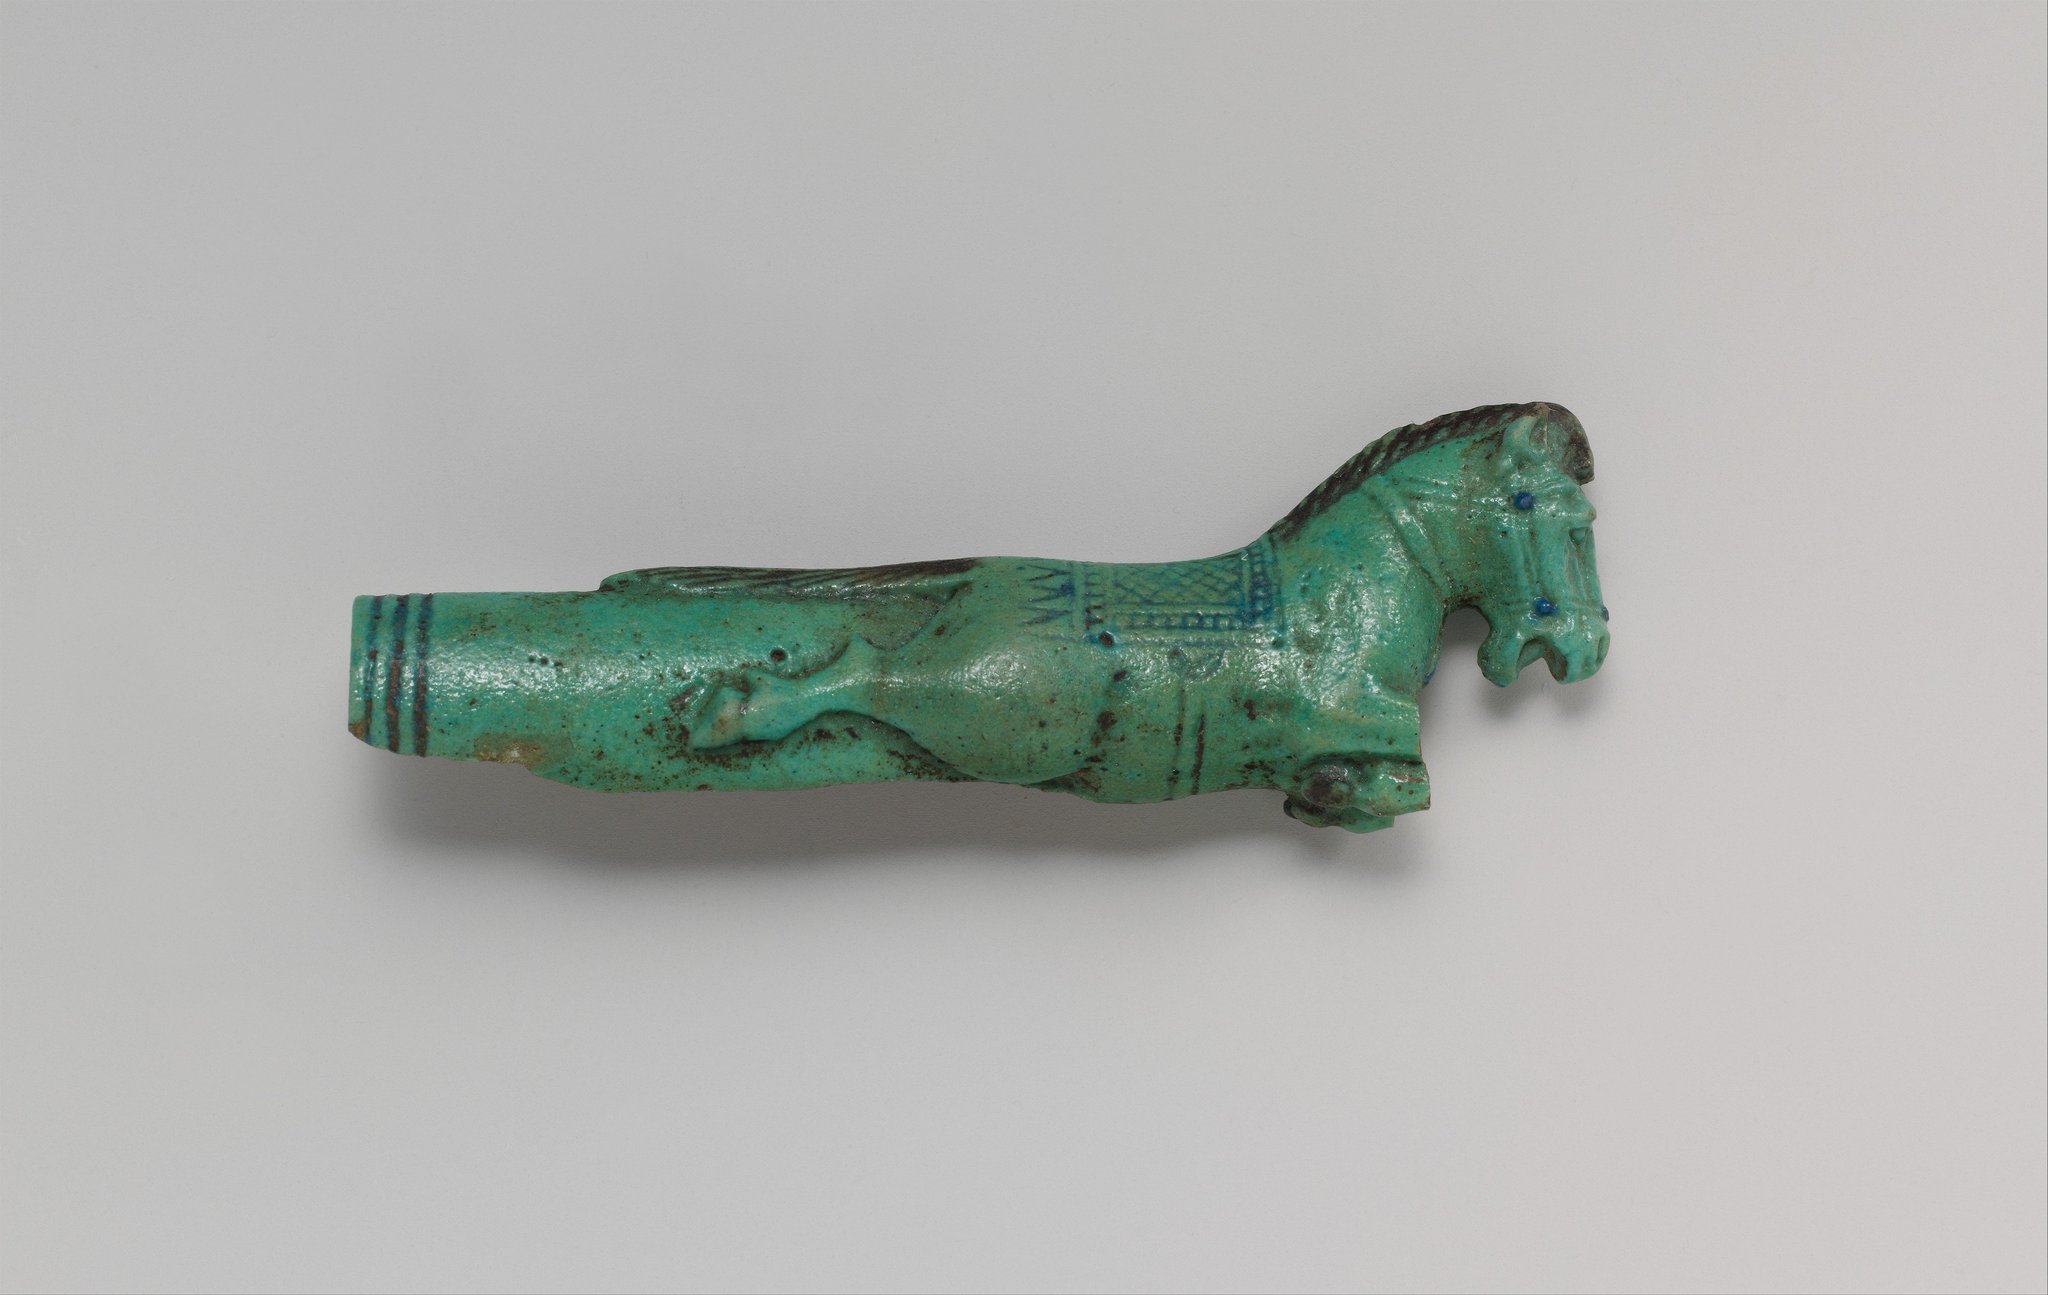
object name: whip handle, horse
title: Whip Handle in the Form of a Horse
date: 525-380 BCE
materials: faience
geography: egypt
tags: horses